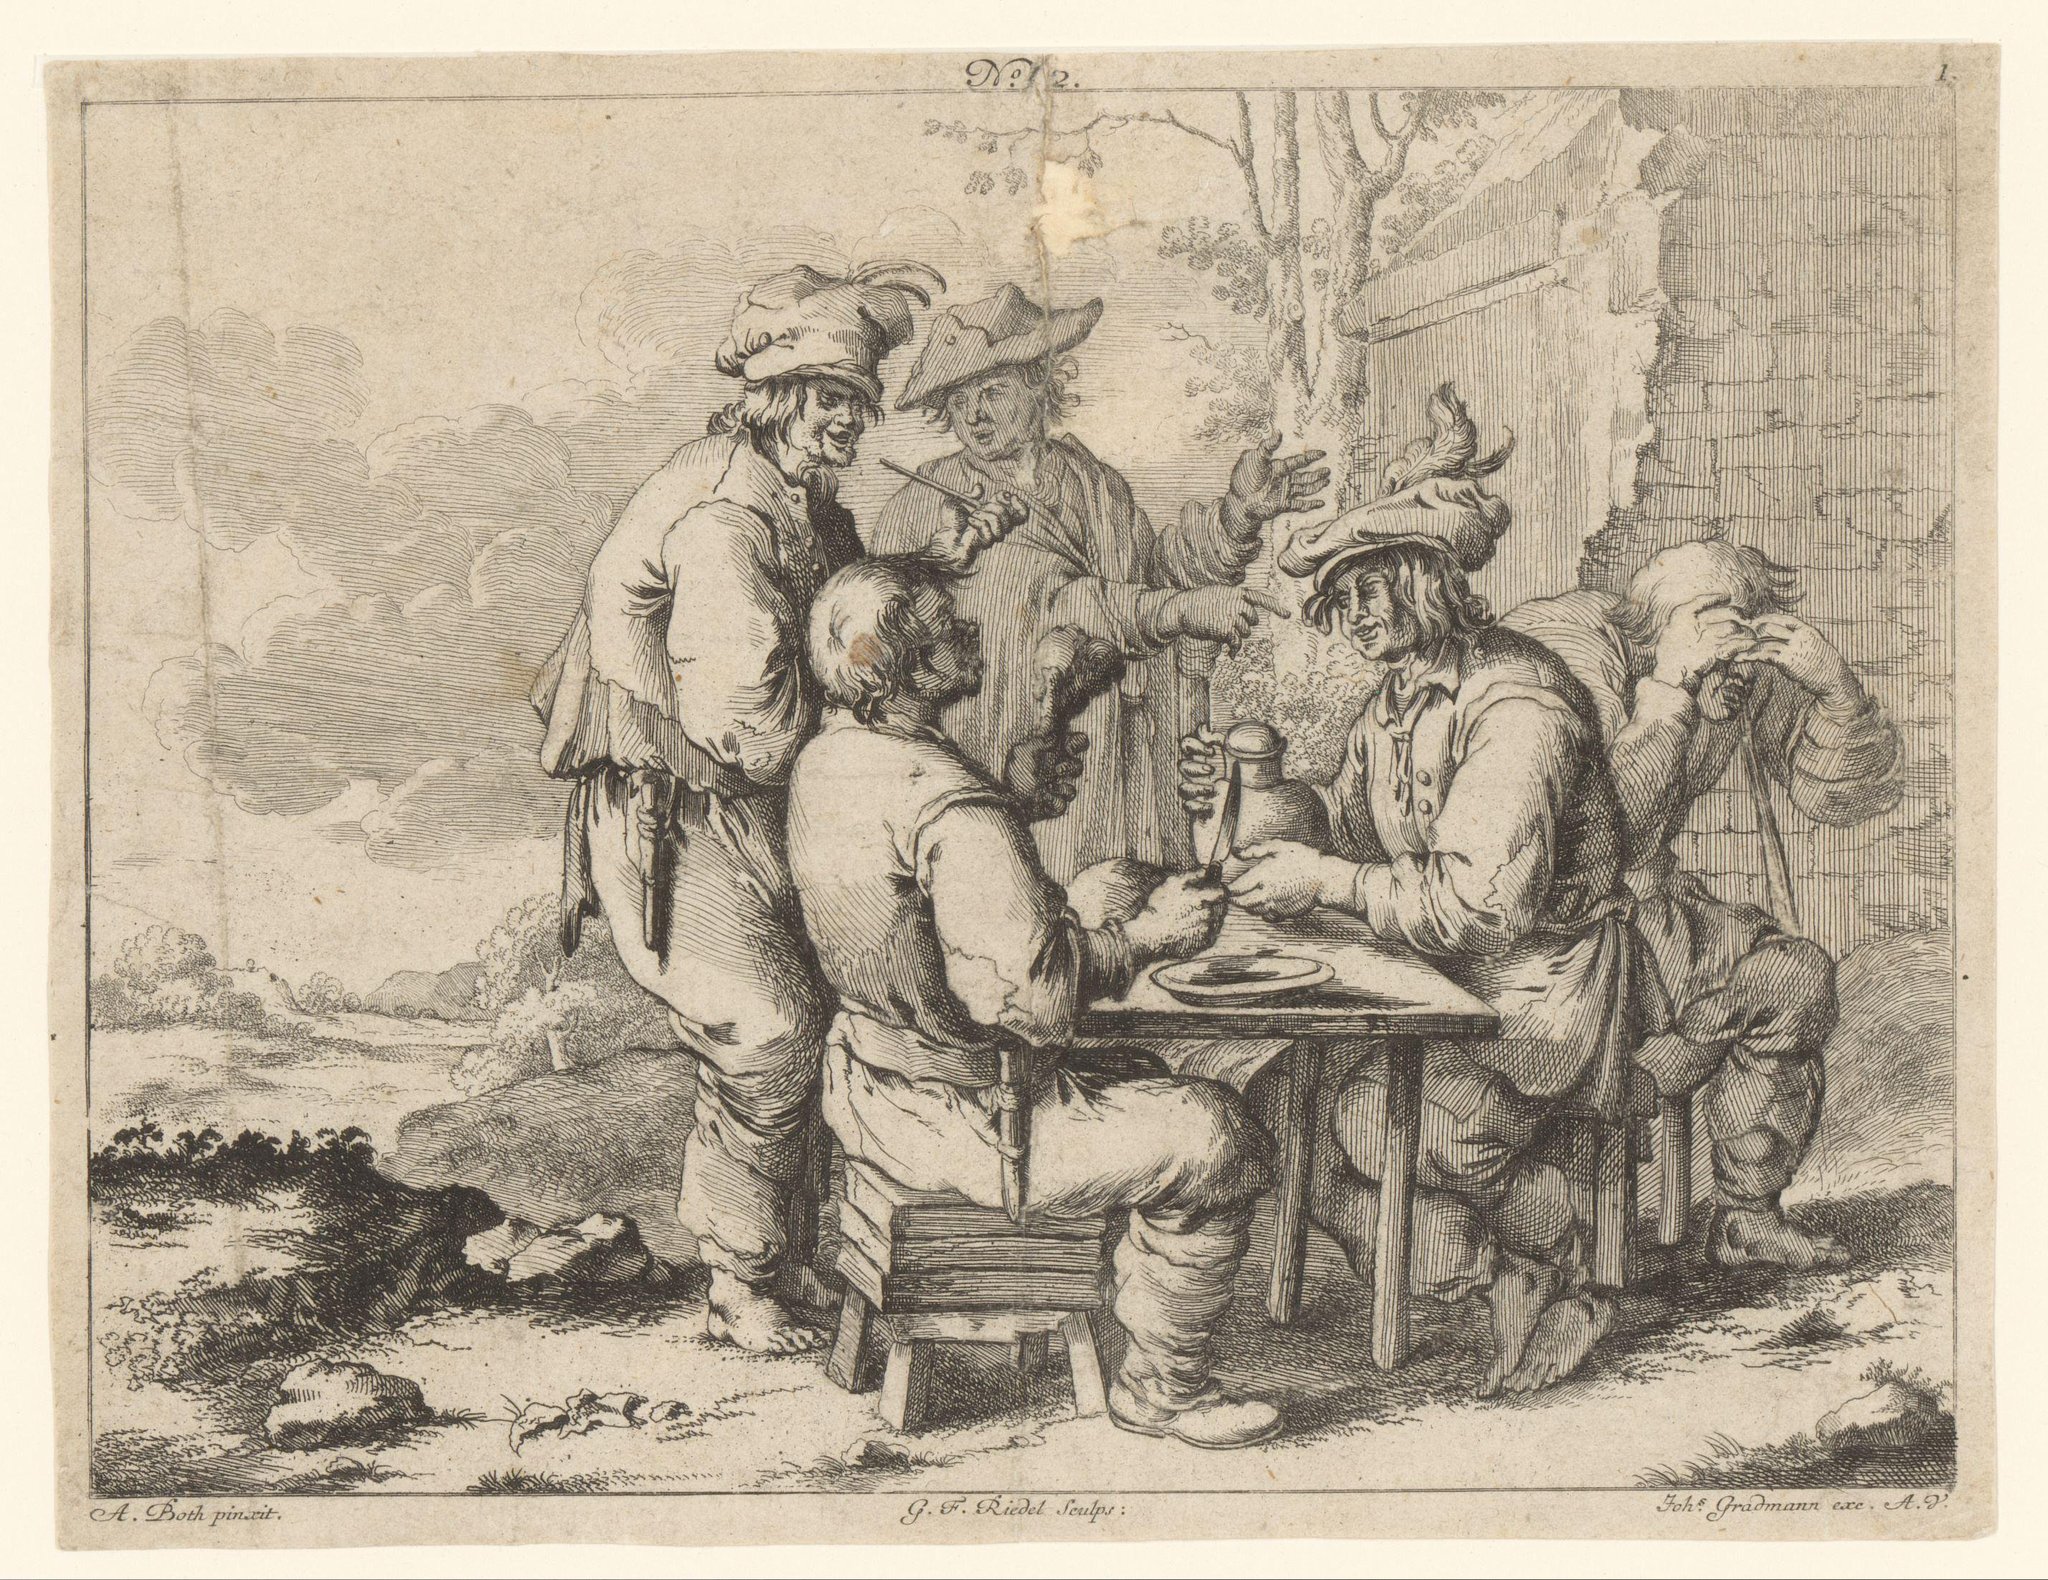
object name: print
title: Landelijke gezelligheid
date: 1734-1784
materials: paper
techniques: etching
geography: augsburg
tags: evening meal, dinner, supper - cc - out of doors, stimulating drinks, vomiting, pipe ~ tobacco, farmers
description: Na de overname van de firma Niemeyer door British American Tabacco Group besloot deze de collectie van het Niemeyer Tabaksmuseum af te stoten. De beheerder van de collectie, het Noordelijk Scheepvaartmuseum, organiseerde in januari 2011 open dagen voor musea waar deze hun voorkeuren voor collectieonderdelen kenbaar konden maken. De objecten zijn getaxeerd door medewerkers van Christie's en vervolgens ter overname aangeboden aan de belangstellende musea. Het Rijksprentenkabinet koos 46 prenten uit de collectie tegen door de medewerkers van Christie's vastgestelde waarde. [H. Leeflang, 2011-06-09]